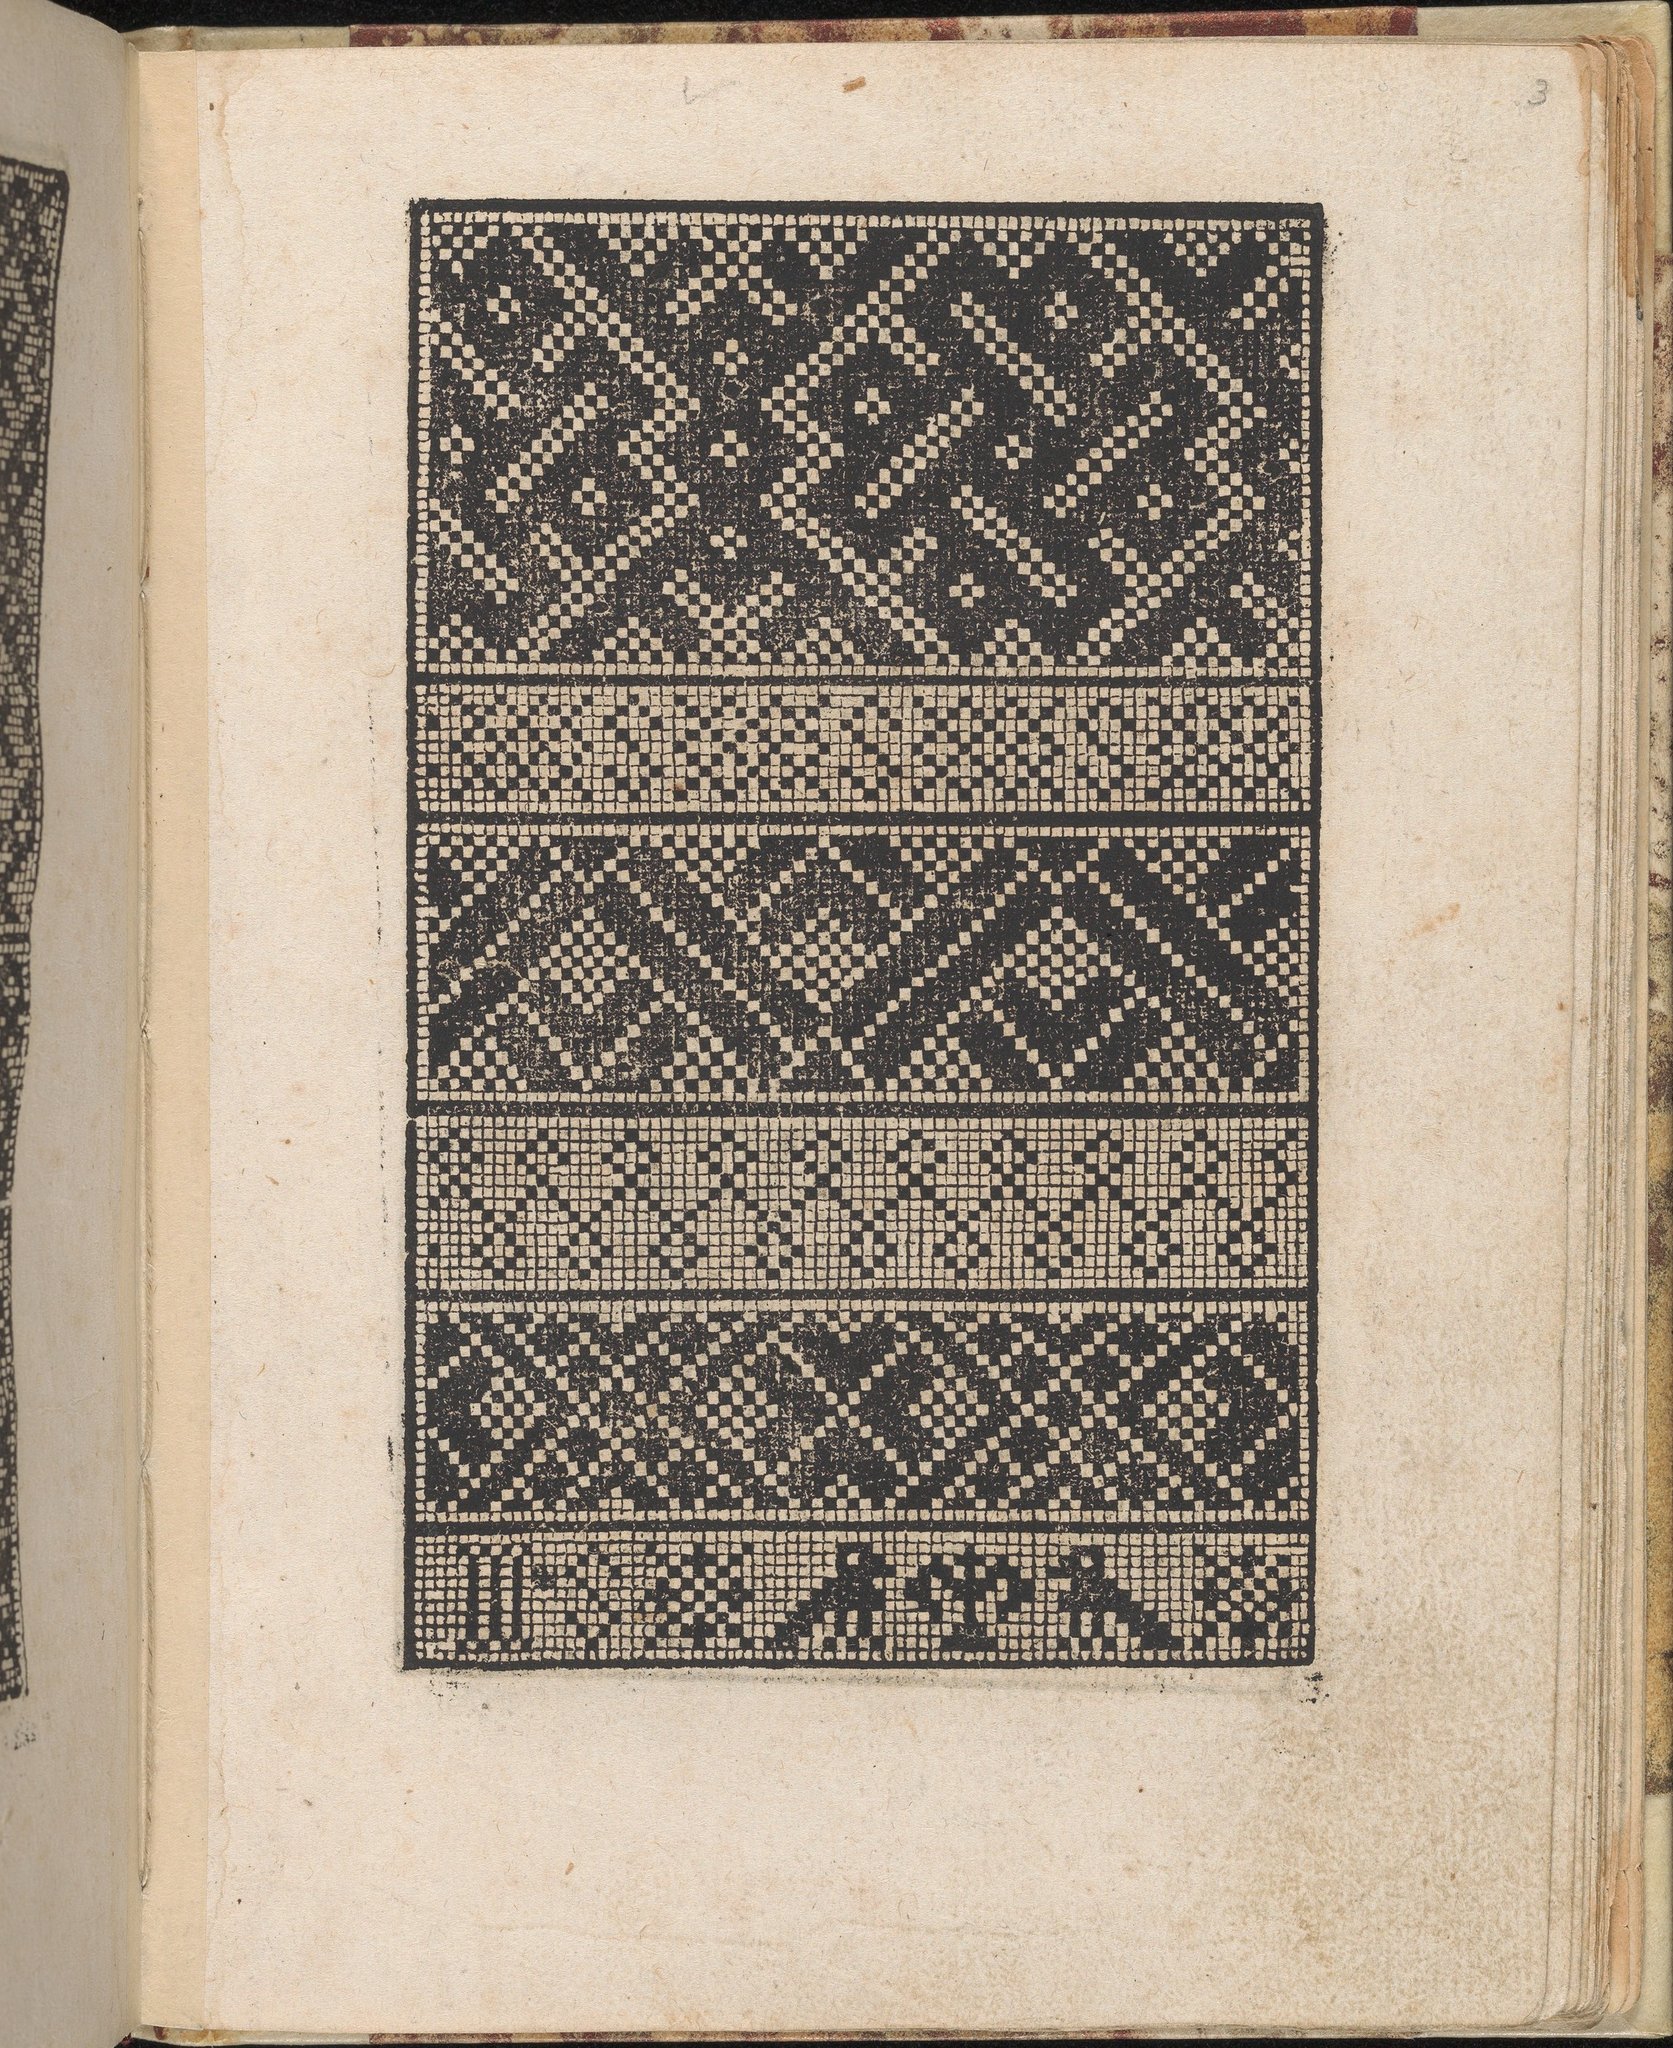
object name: book print ornament architecture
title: Ein new getruckt model Büchli...Page 3, recto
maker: johann schönsperger the younger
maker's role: publisher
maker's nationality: german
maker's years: 1490-1550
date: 1529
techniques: woodcut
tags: ornament